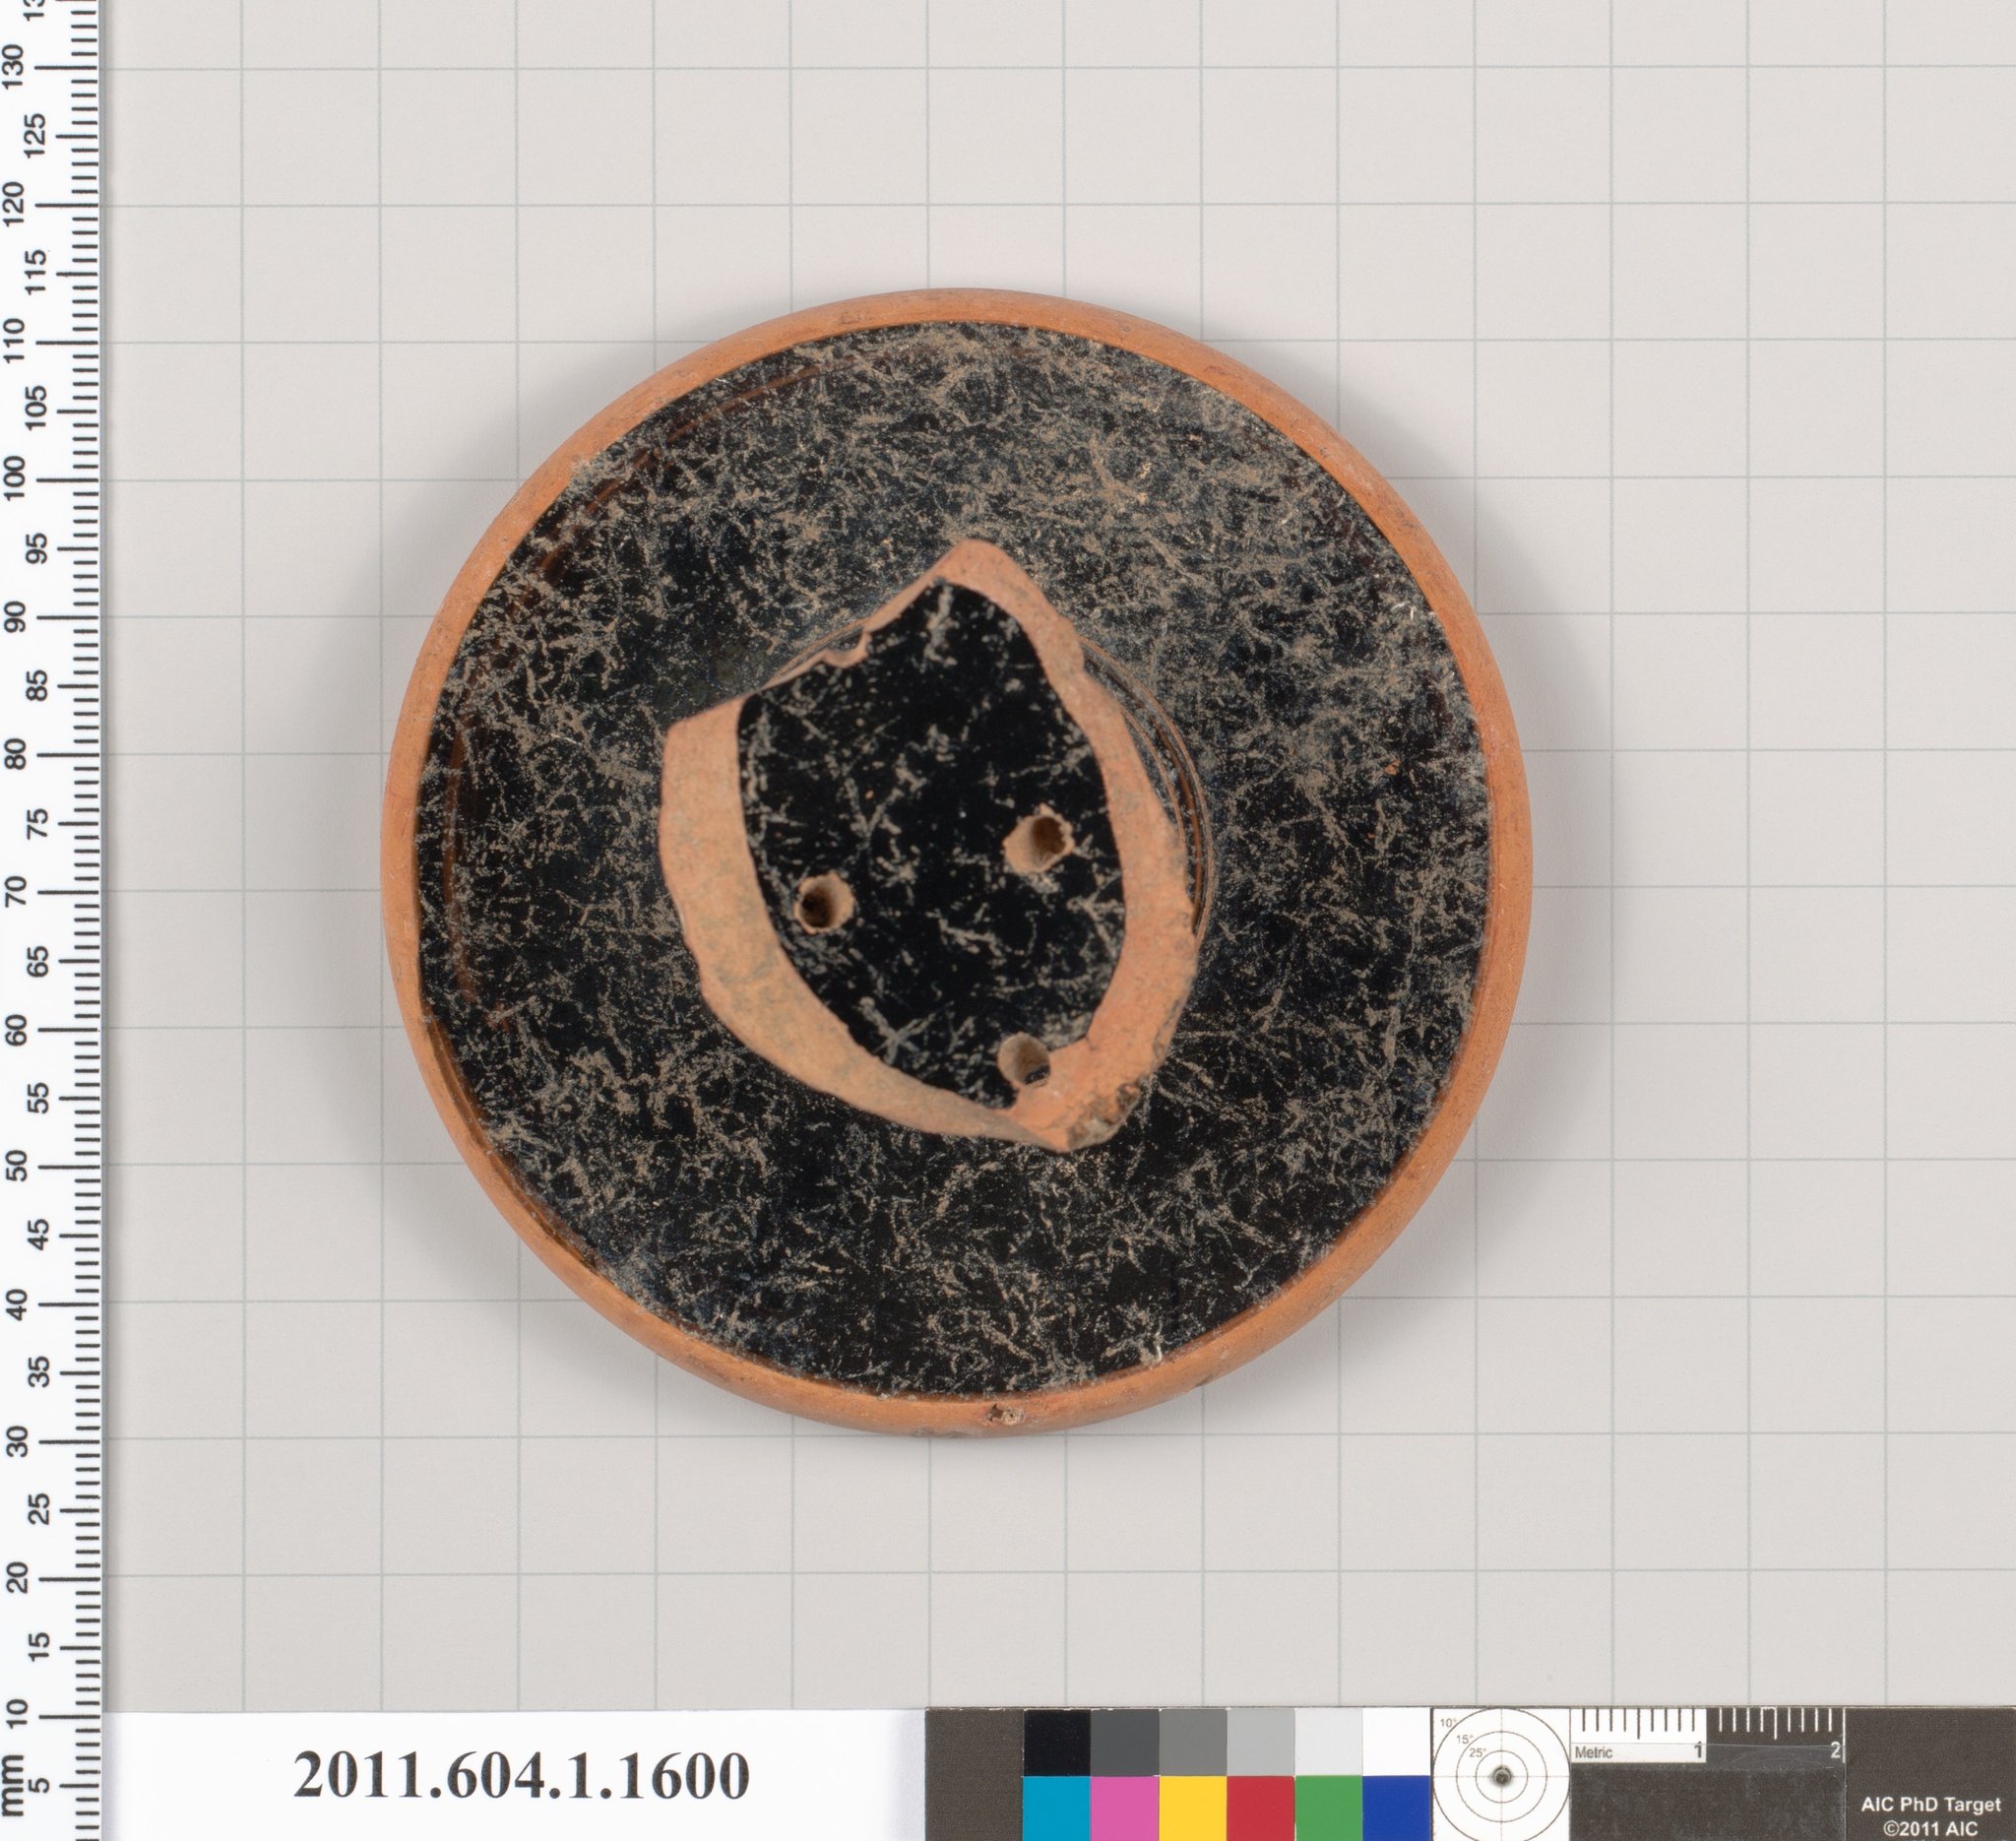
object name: kylix fragment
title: Terracotta fragment of a kylix (drinking cup)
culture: greek, attic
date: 500-401 BCE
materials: terracotta